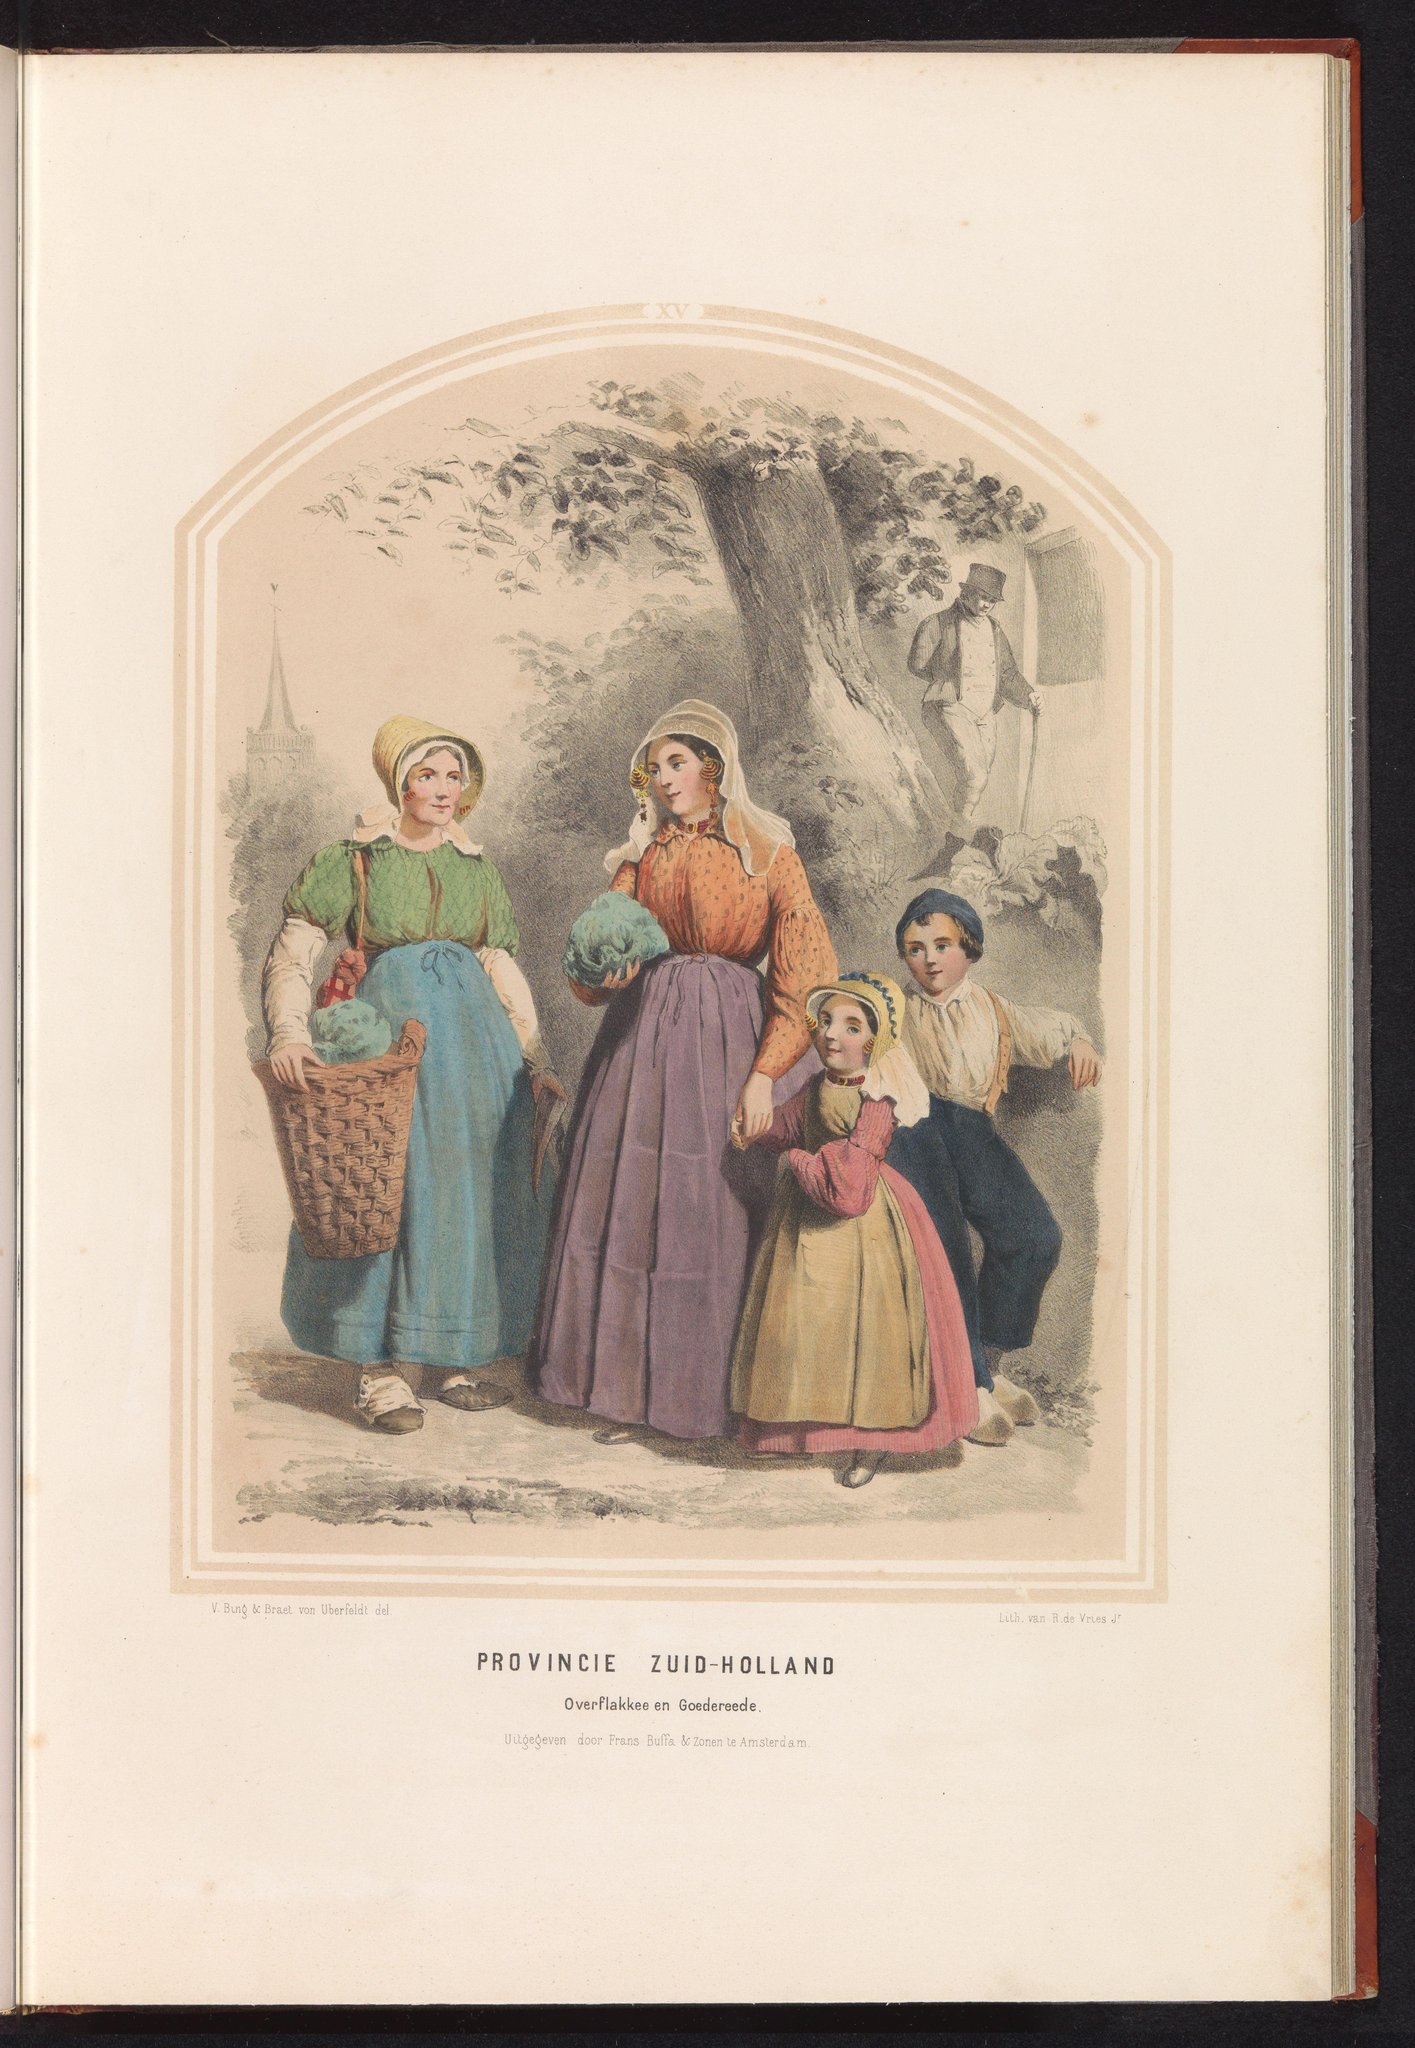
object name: costume print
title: Provincie Zuid-Holland Overflakkee en Goedereede / XV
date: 1857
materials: paper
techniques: hand coloring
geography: amsterdam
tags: folk costume, regional costume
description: Klederdracht van Overflakkee en Goedereede (Goeree-Overflakkee) in de provincie Zuid-Holland. Twee vrouwen en twee kinderen. Illustratie in een boek uit 1857 met 56 platen van Nederlandse klederdrachten.